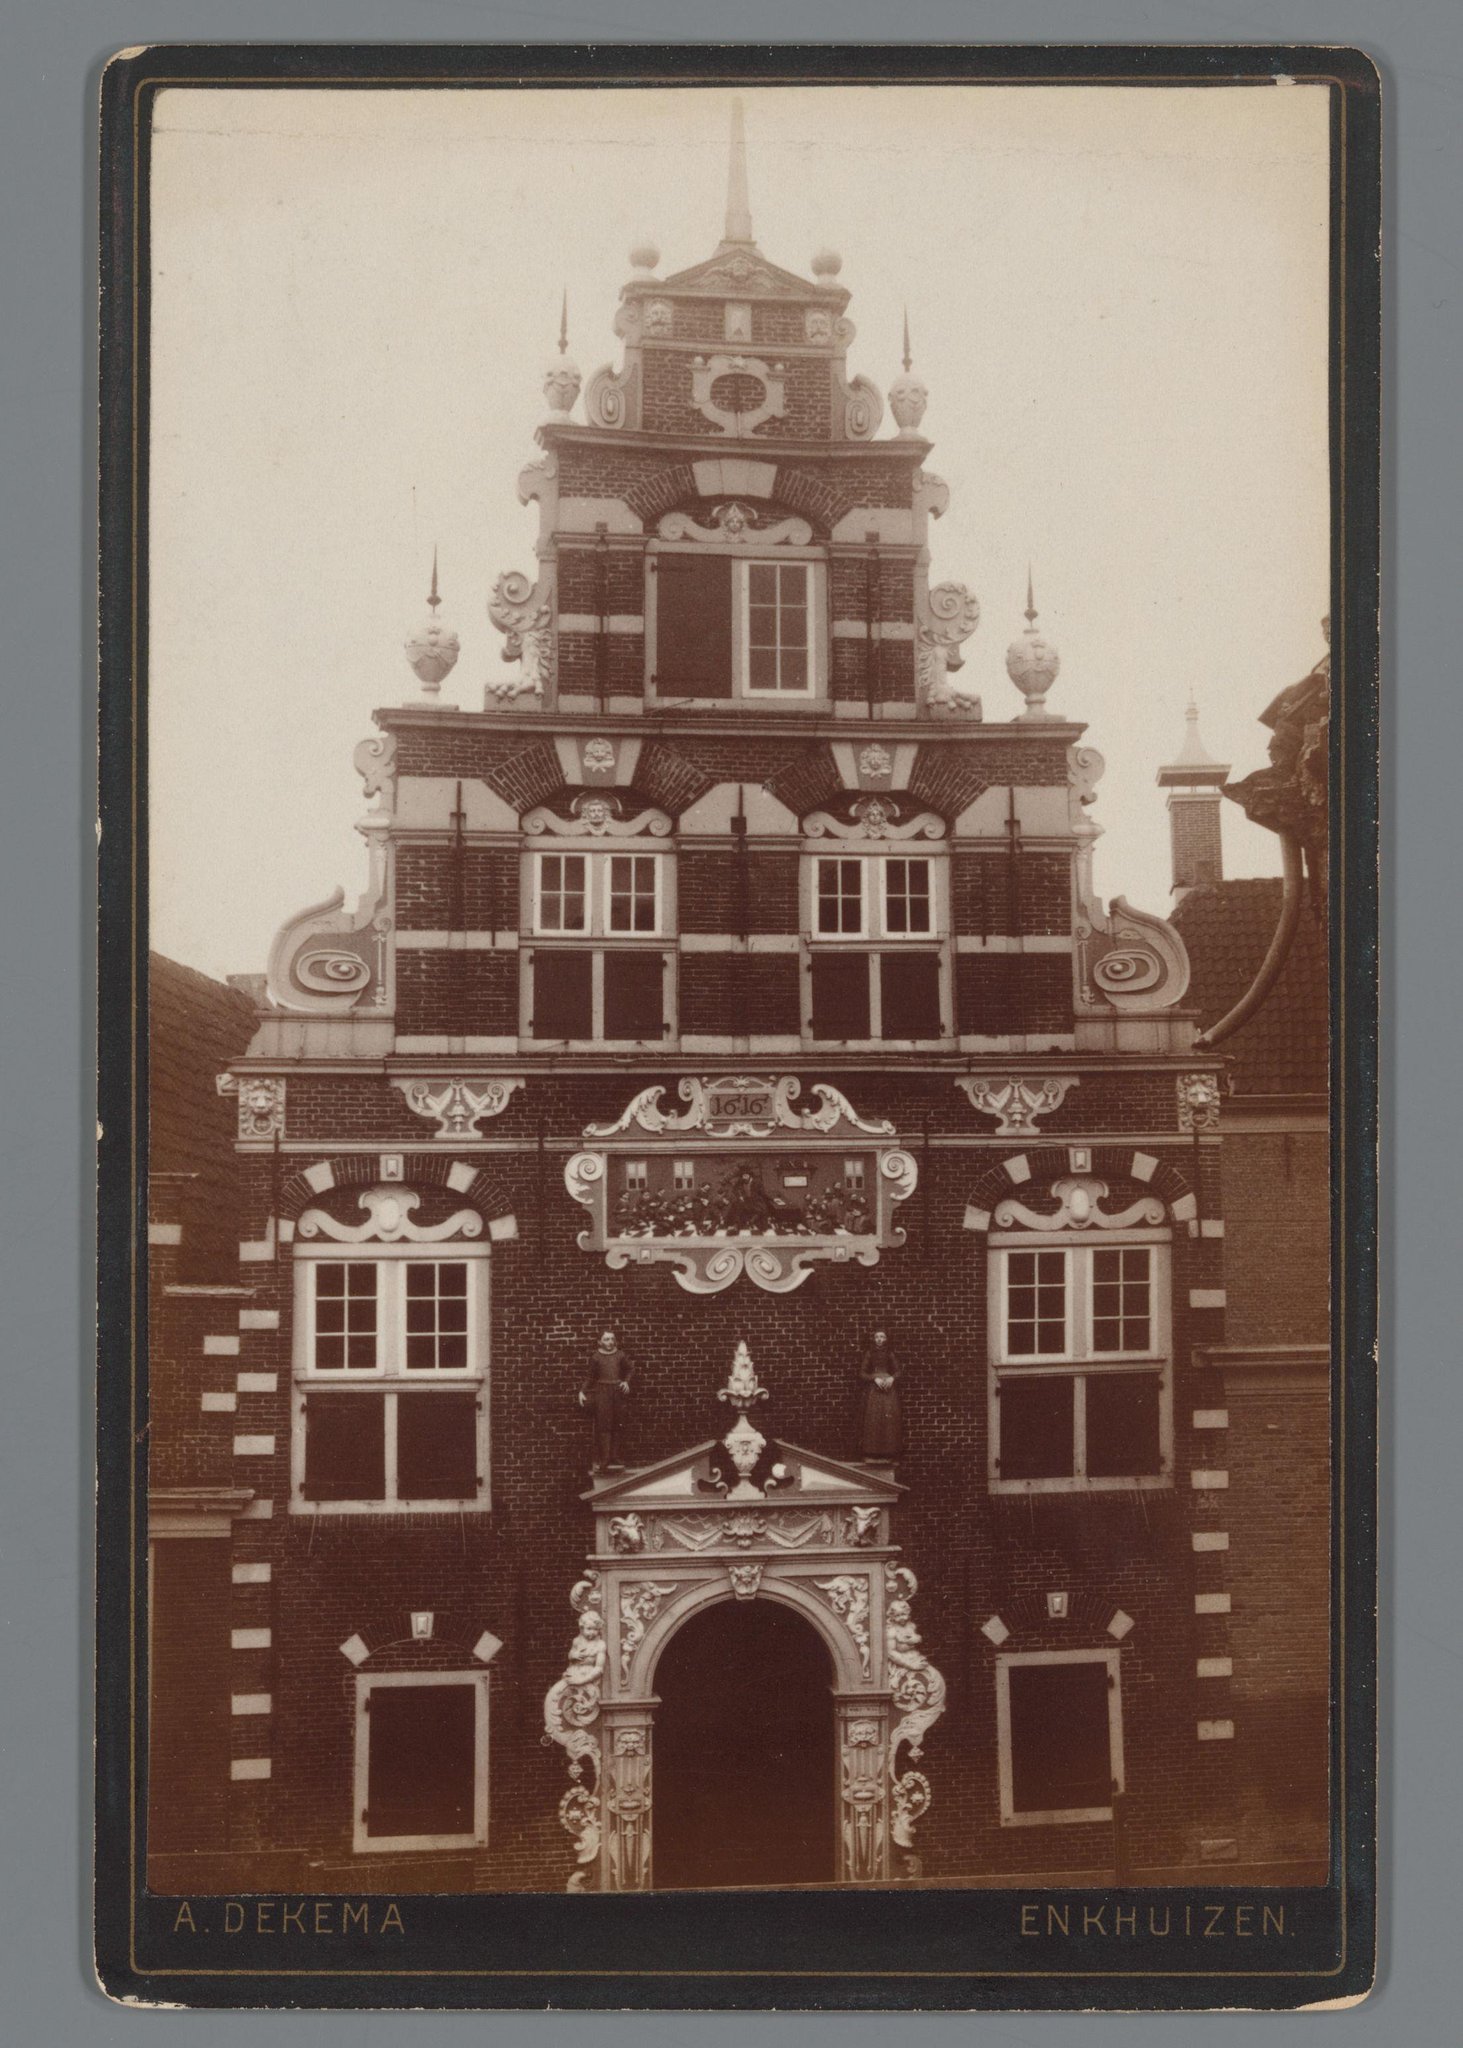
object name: photograph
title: Gevel van het weeshuis te Enkhuizen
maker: albert dekema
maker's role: publisher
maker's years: 1824-1909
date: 1865-1896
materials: cardboard, photographic support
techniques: albumen print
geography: enkhuizen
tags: gate, entrance, orphanage, enkhuizen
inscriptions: annotation: ‘Weeshuis/ Enkhuizen’